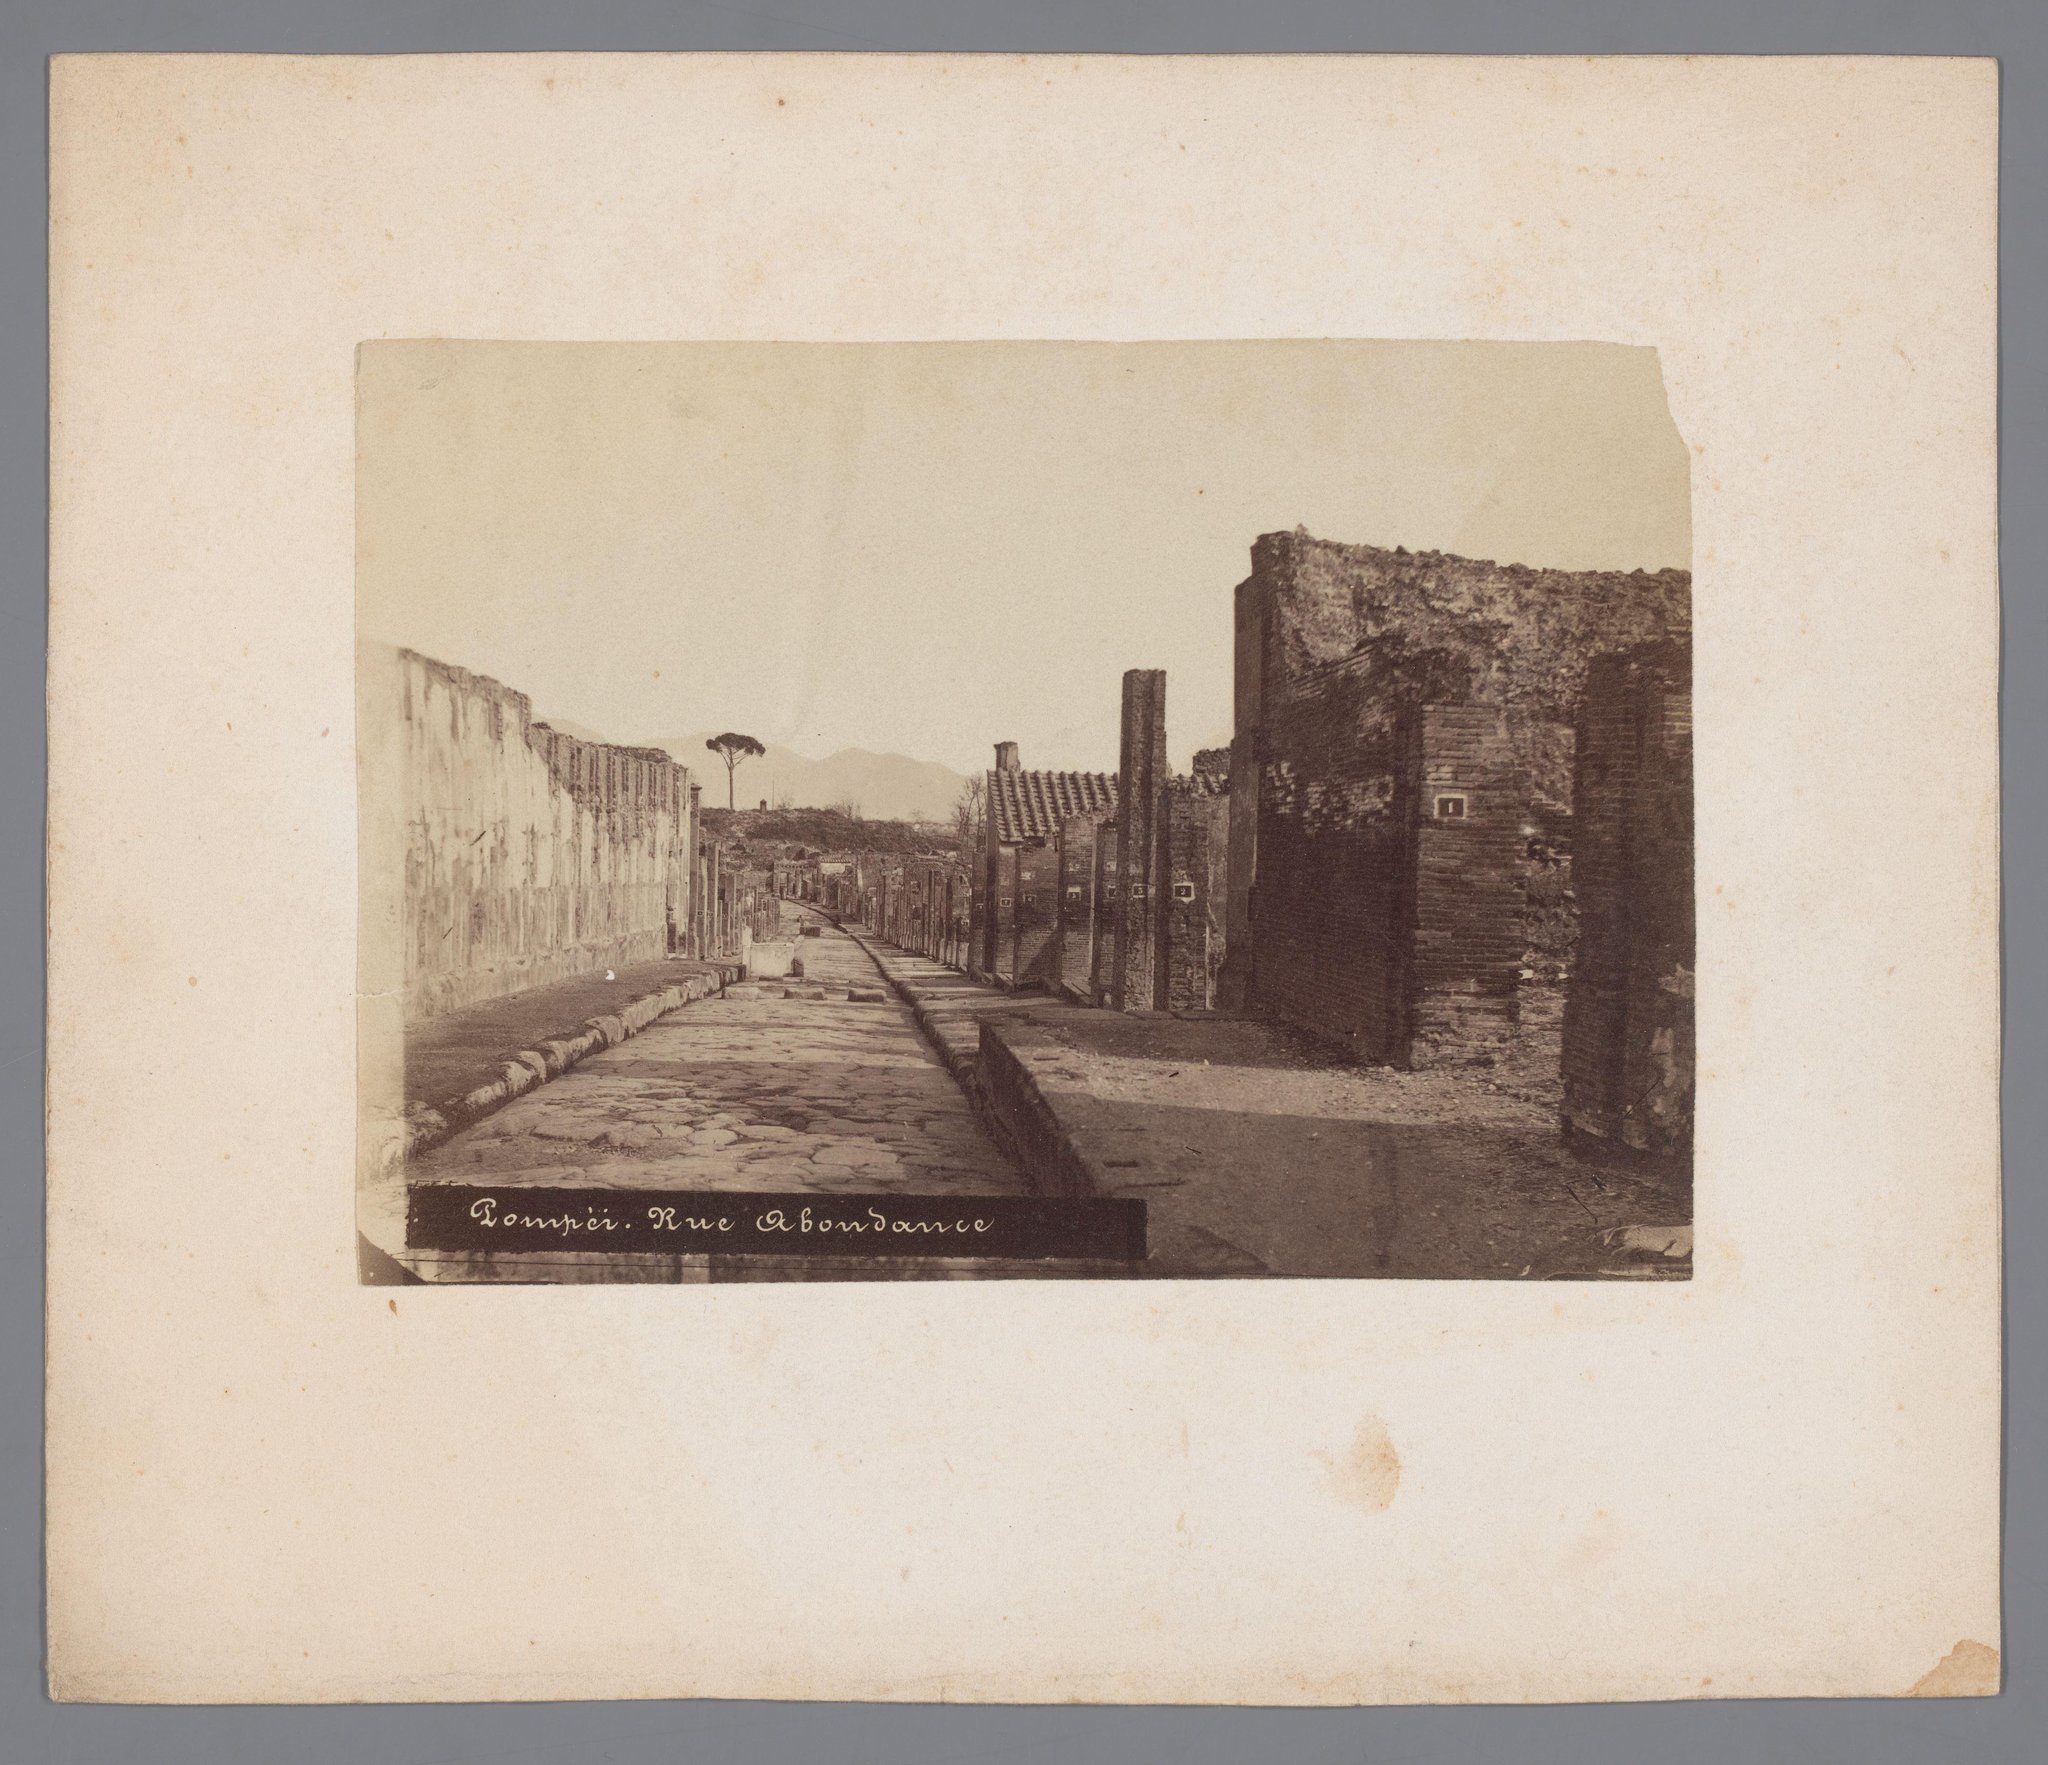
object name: photograph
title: Gezicht op de Via dell'Abbondanza te Pompeï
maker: giorgio sommer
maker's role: fotograaf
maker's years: 1834-1914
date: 1857-1914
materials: cardboard, paper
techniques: albumen print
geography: pompeii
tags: devastated, ruined place or city (~ warfare), street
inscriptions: collector's mark: ‘VOSMAER’, inscription: ‘11’, inscription: ‘Sommer (t)’